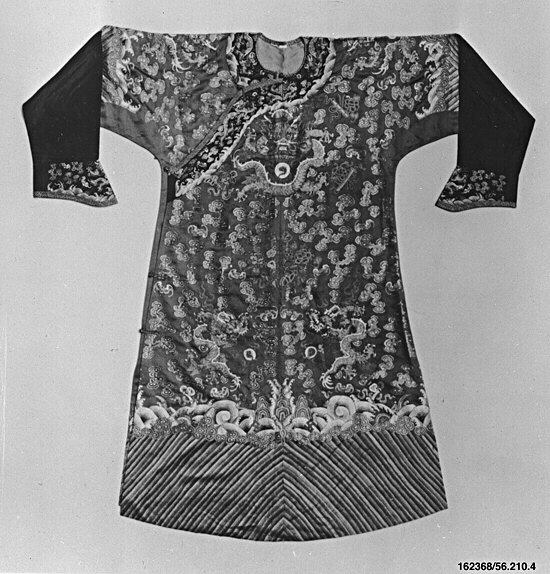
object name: robe, imperial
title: Imperial Robe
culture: chinese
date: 1801-1900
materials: silk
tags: dragons